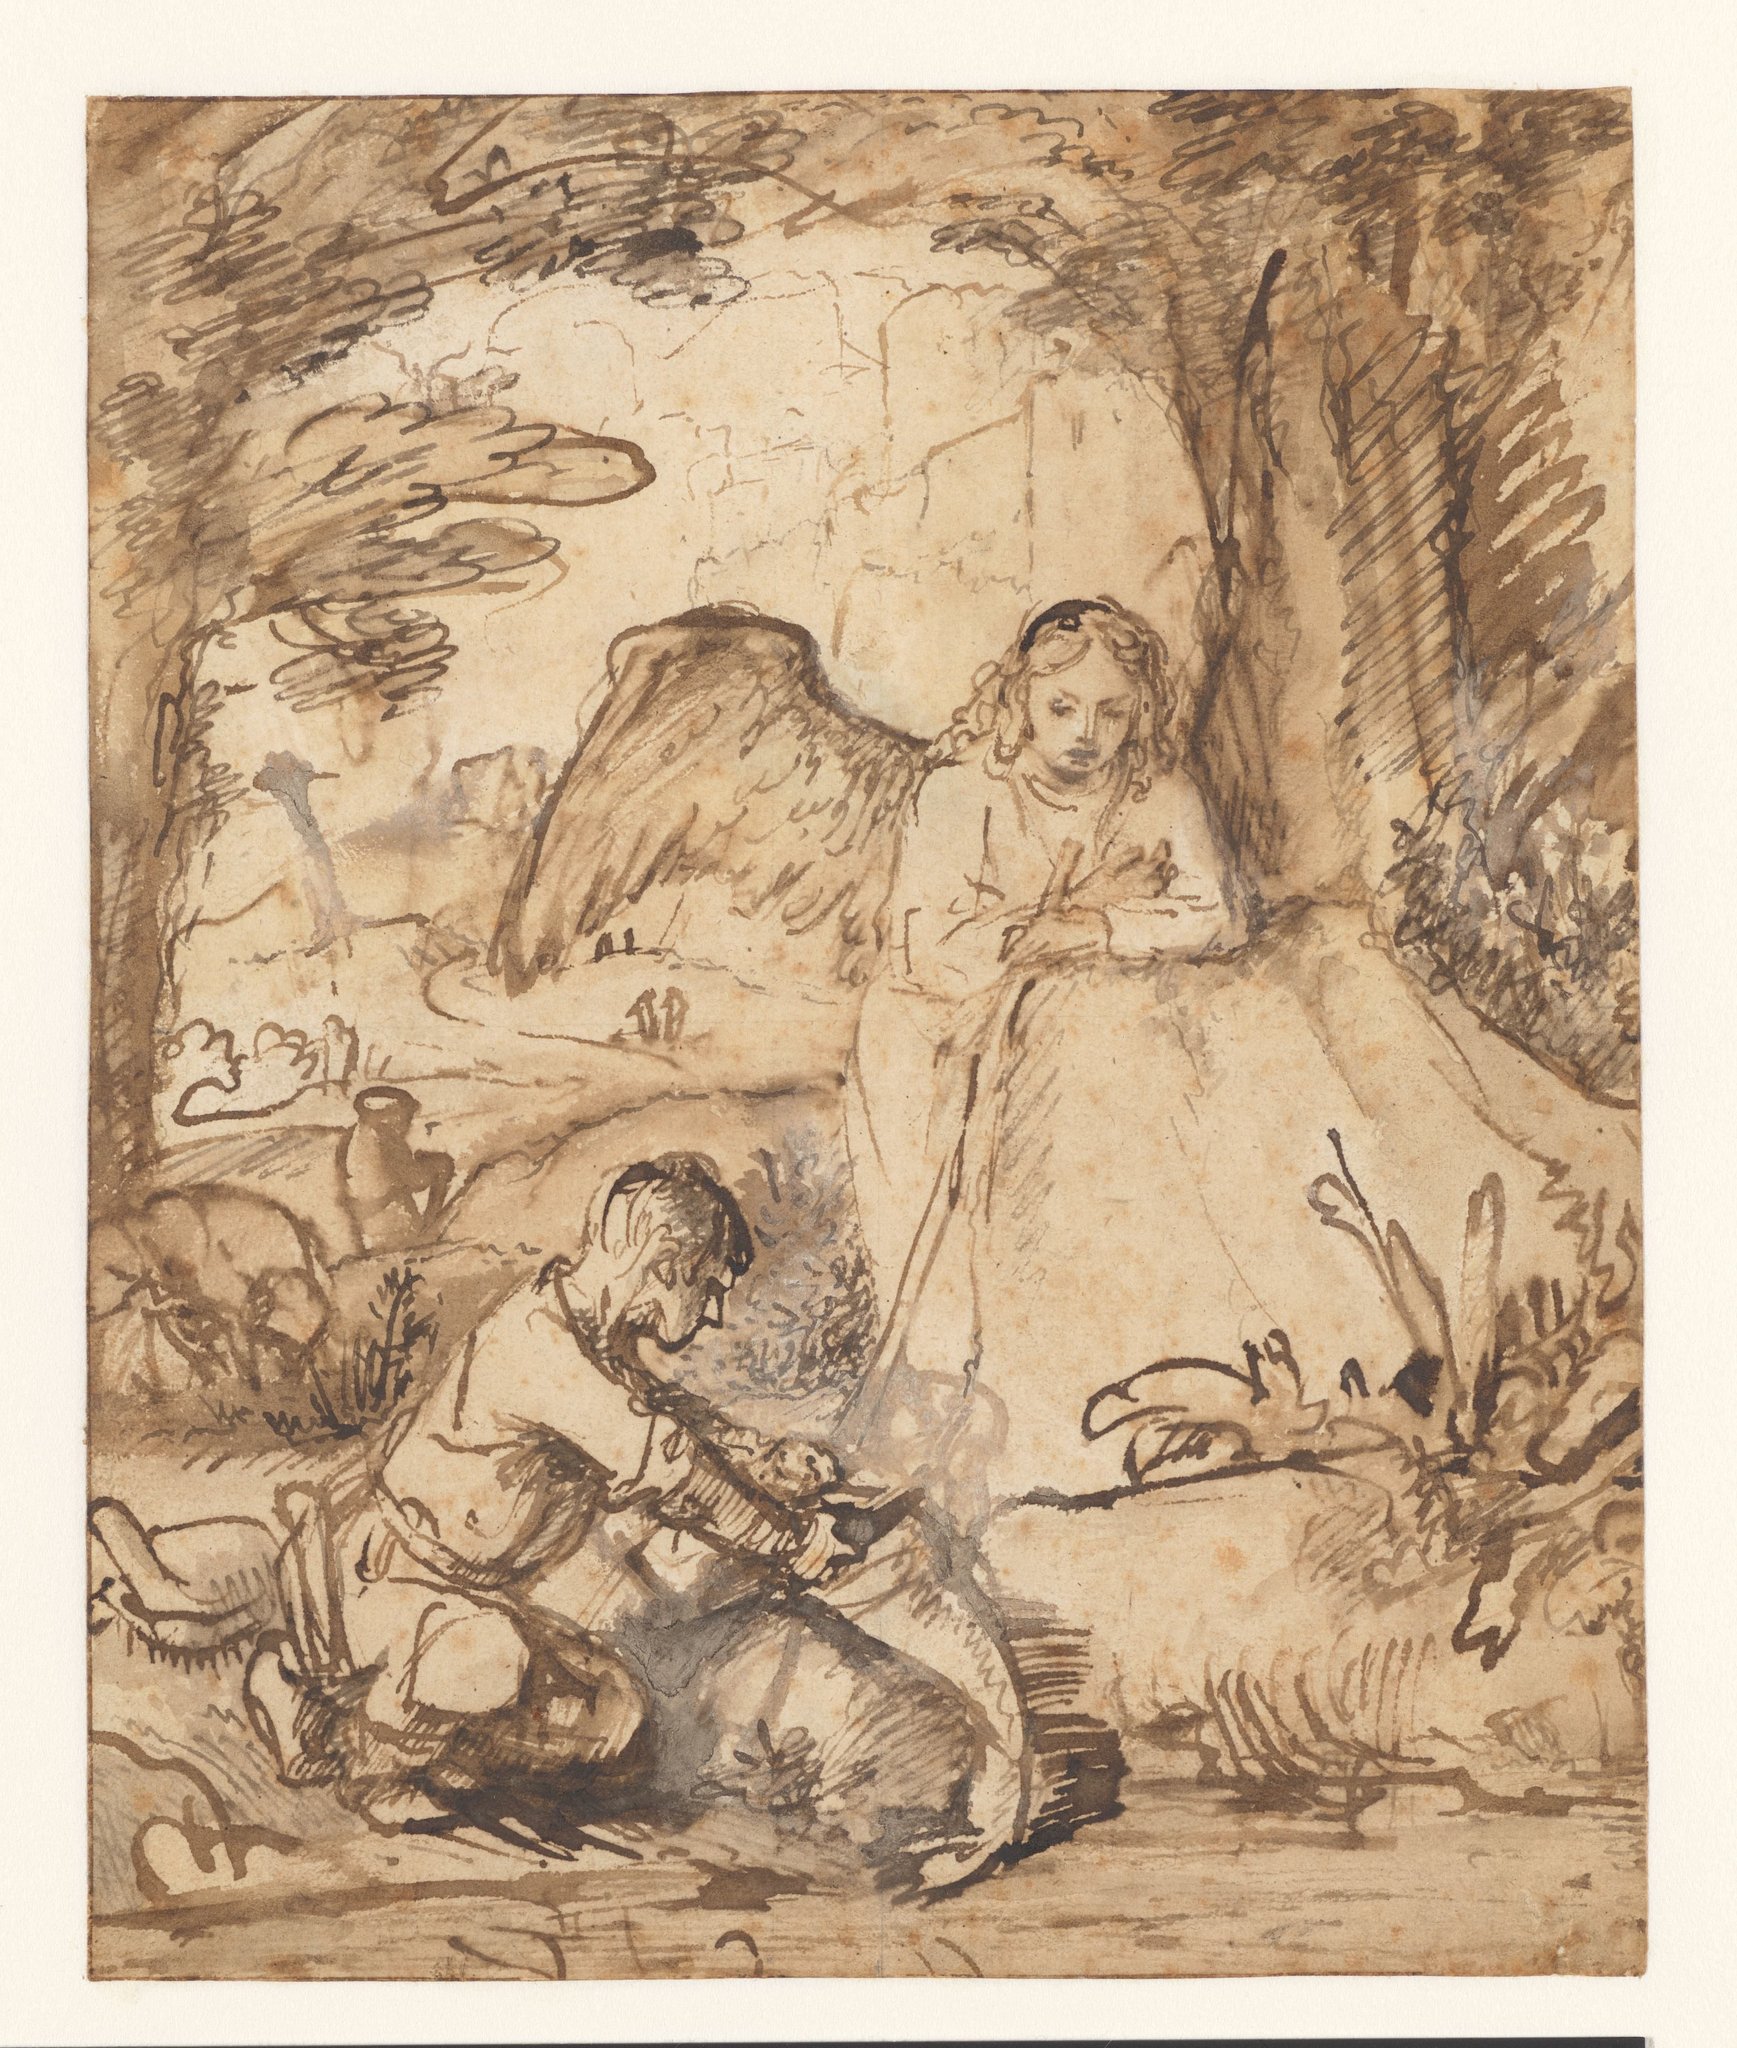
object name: drawing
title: Tobias en de vis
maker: philips koninck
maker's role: draughtsman, painter, print maker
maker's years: 1619-1688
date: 1641-1645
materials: paint, ink, paper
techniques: brush, pen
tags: tobias cuts up the fish and removes the heart, liver and gall